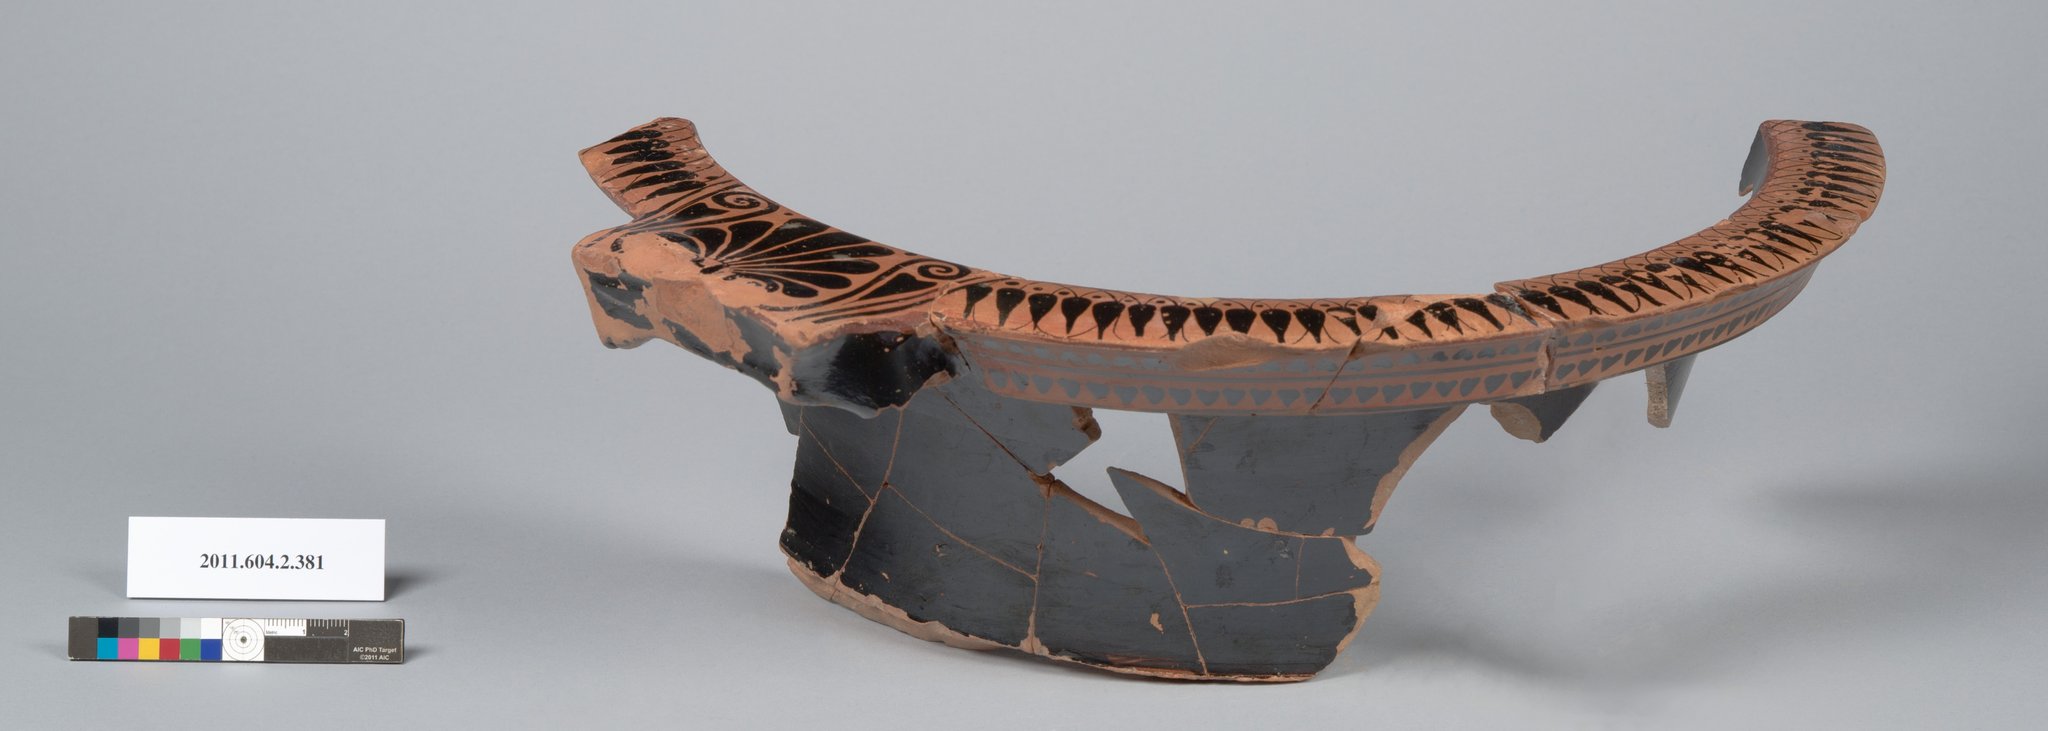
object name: column krater fragment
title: Terracotta fragment of a column-krater (bowl for mixing wine and water)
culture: greek, attic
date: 460-440 BCE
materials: terracotta